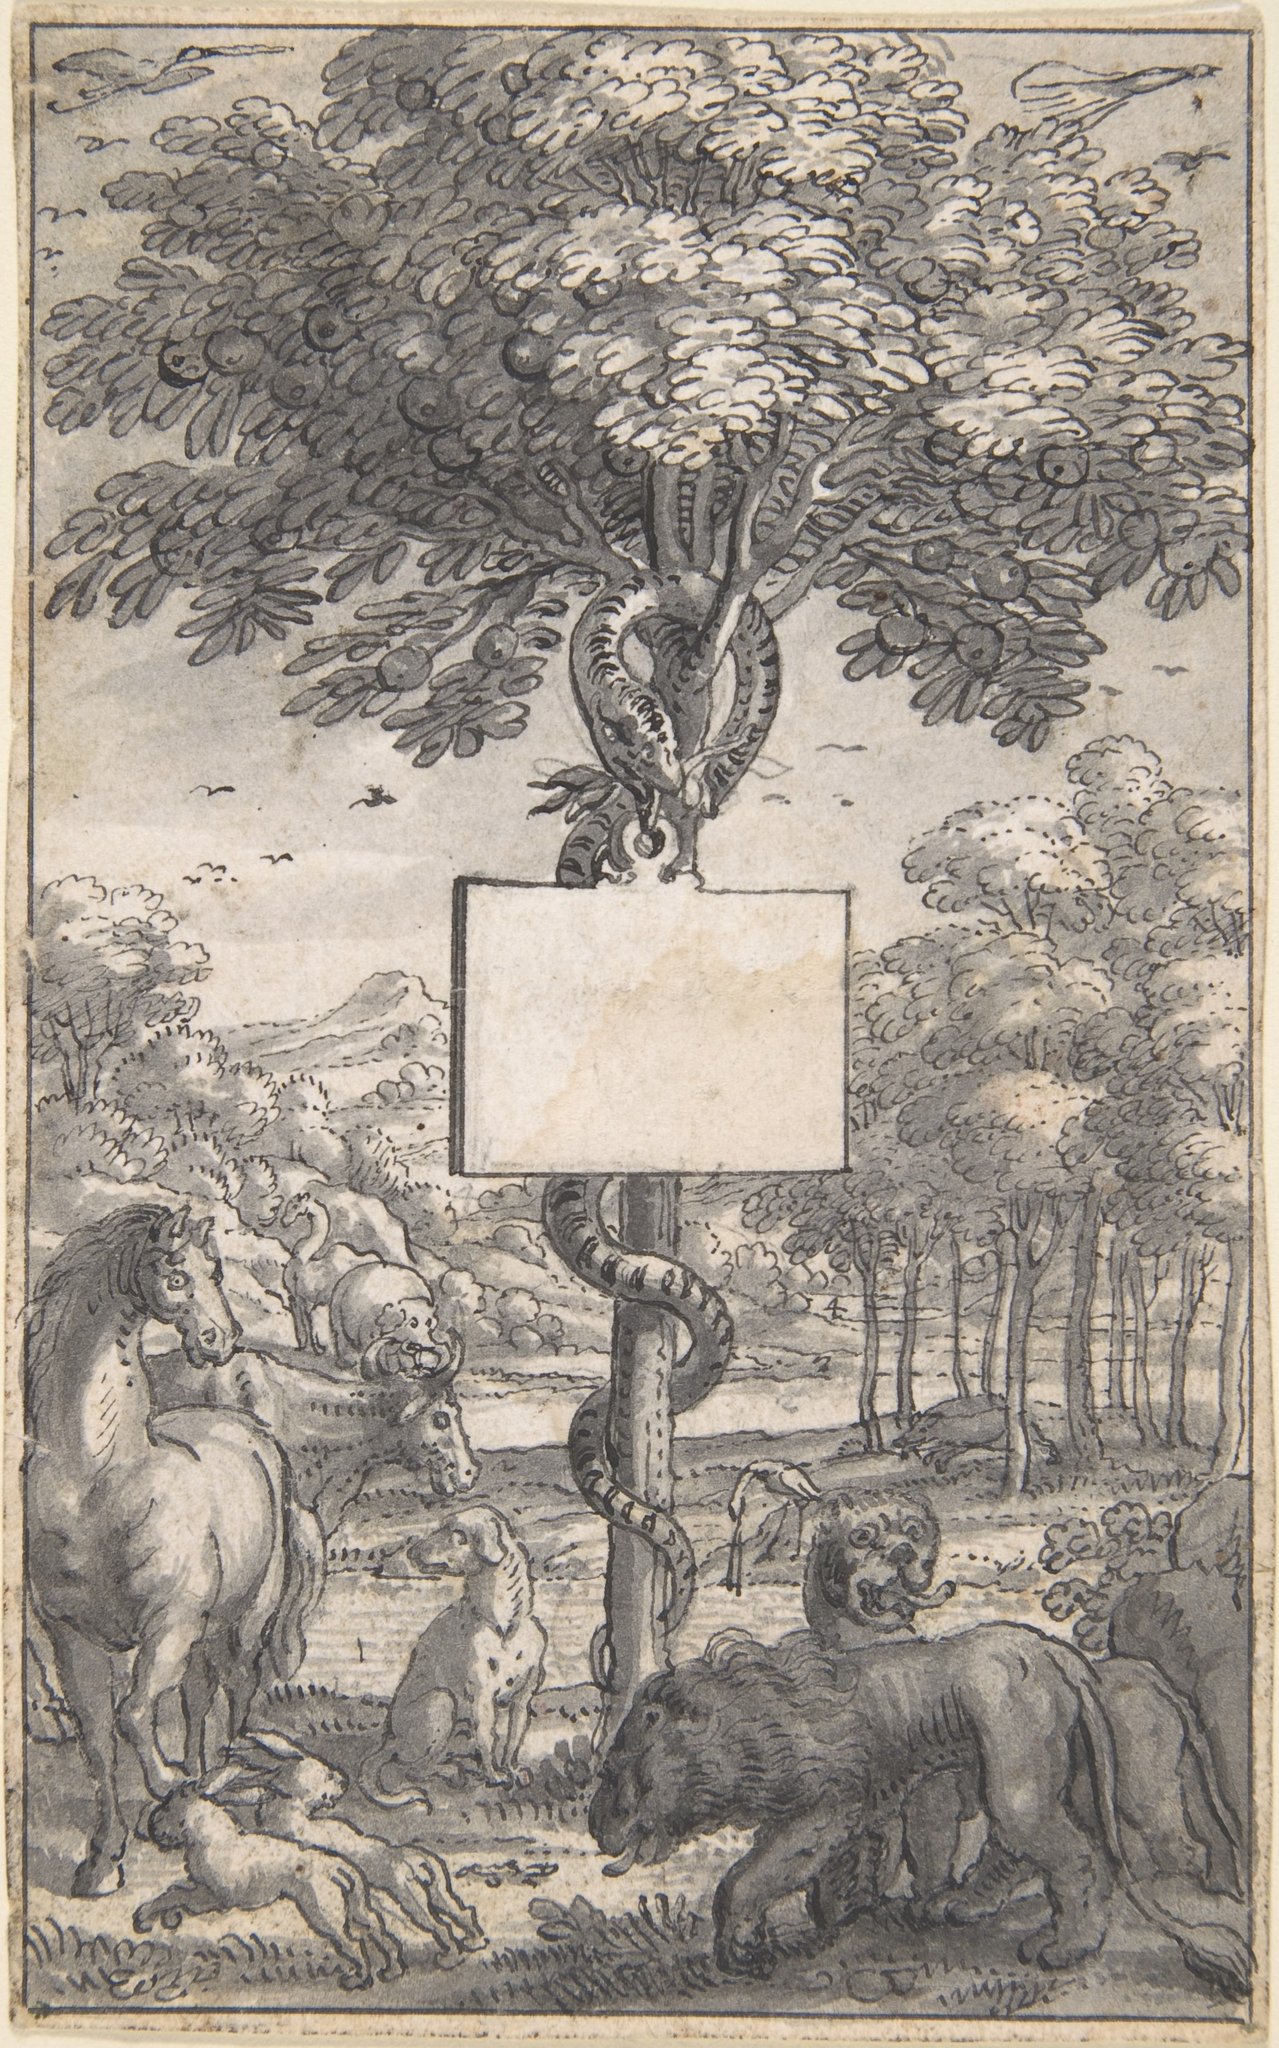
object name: drawing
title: Designs for Book Illustrations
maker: anonymous, netherlandish, 16th century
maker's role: artist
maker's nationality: netherlandish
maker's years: 1500-1600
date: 1501-1600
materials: chalk, ink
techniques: brush, incising, pen, transfer, wash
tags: horses,lions,rabbits,snakes,trees